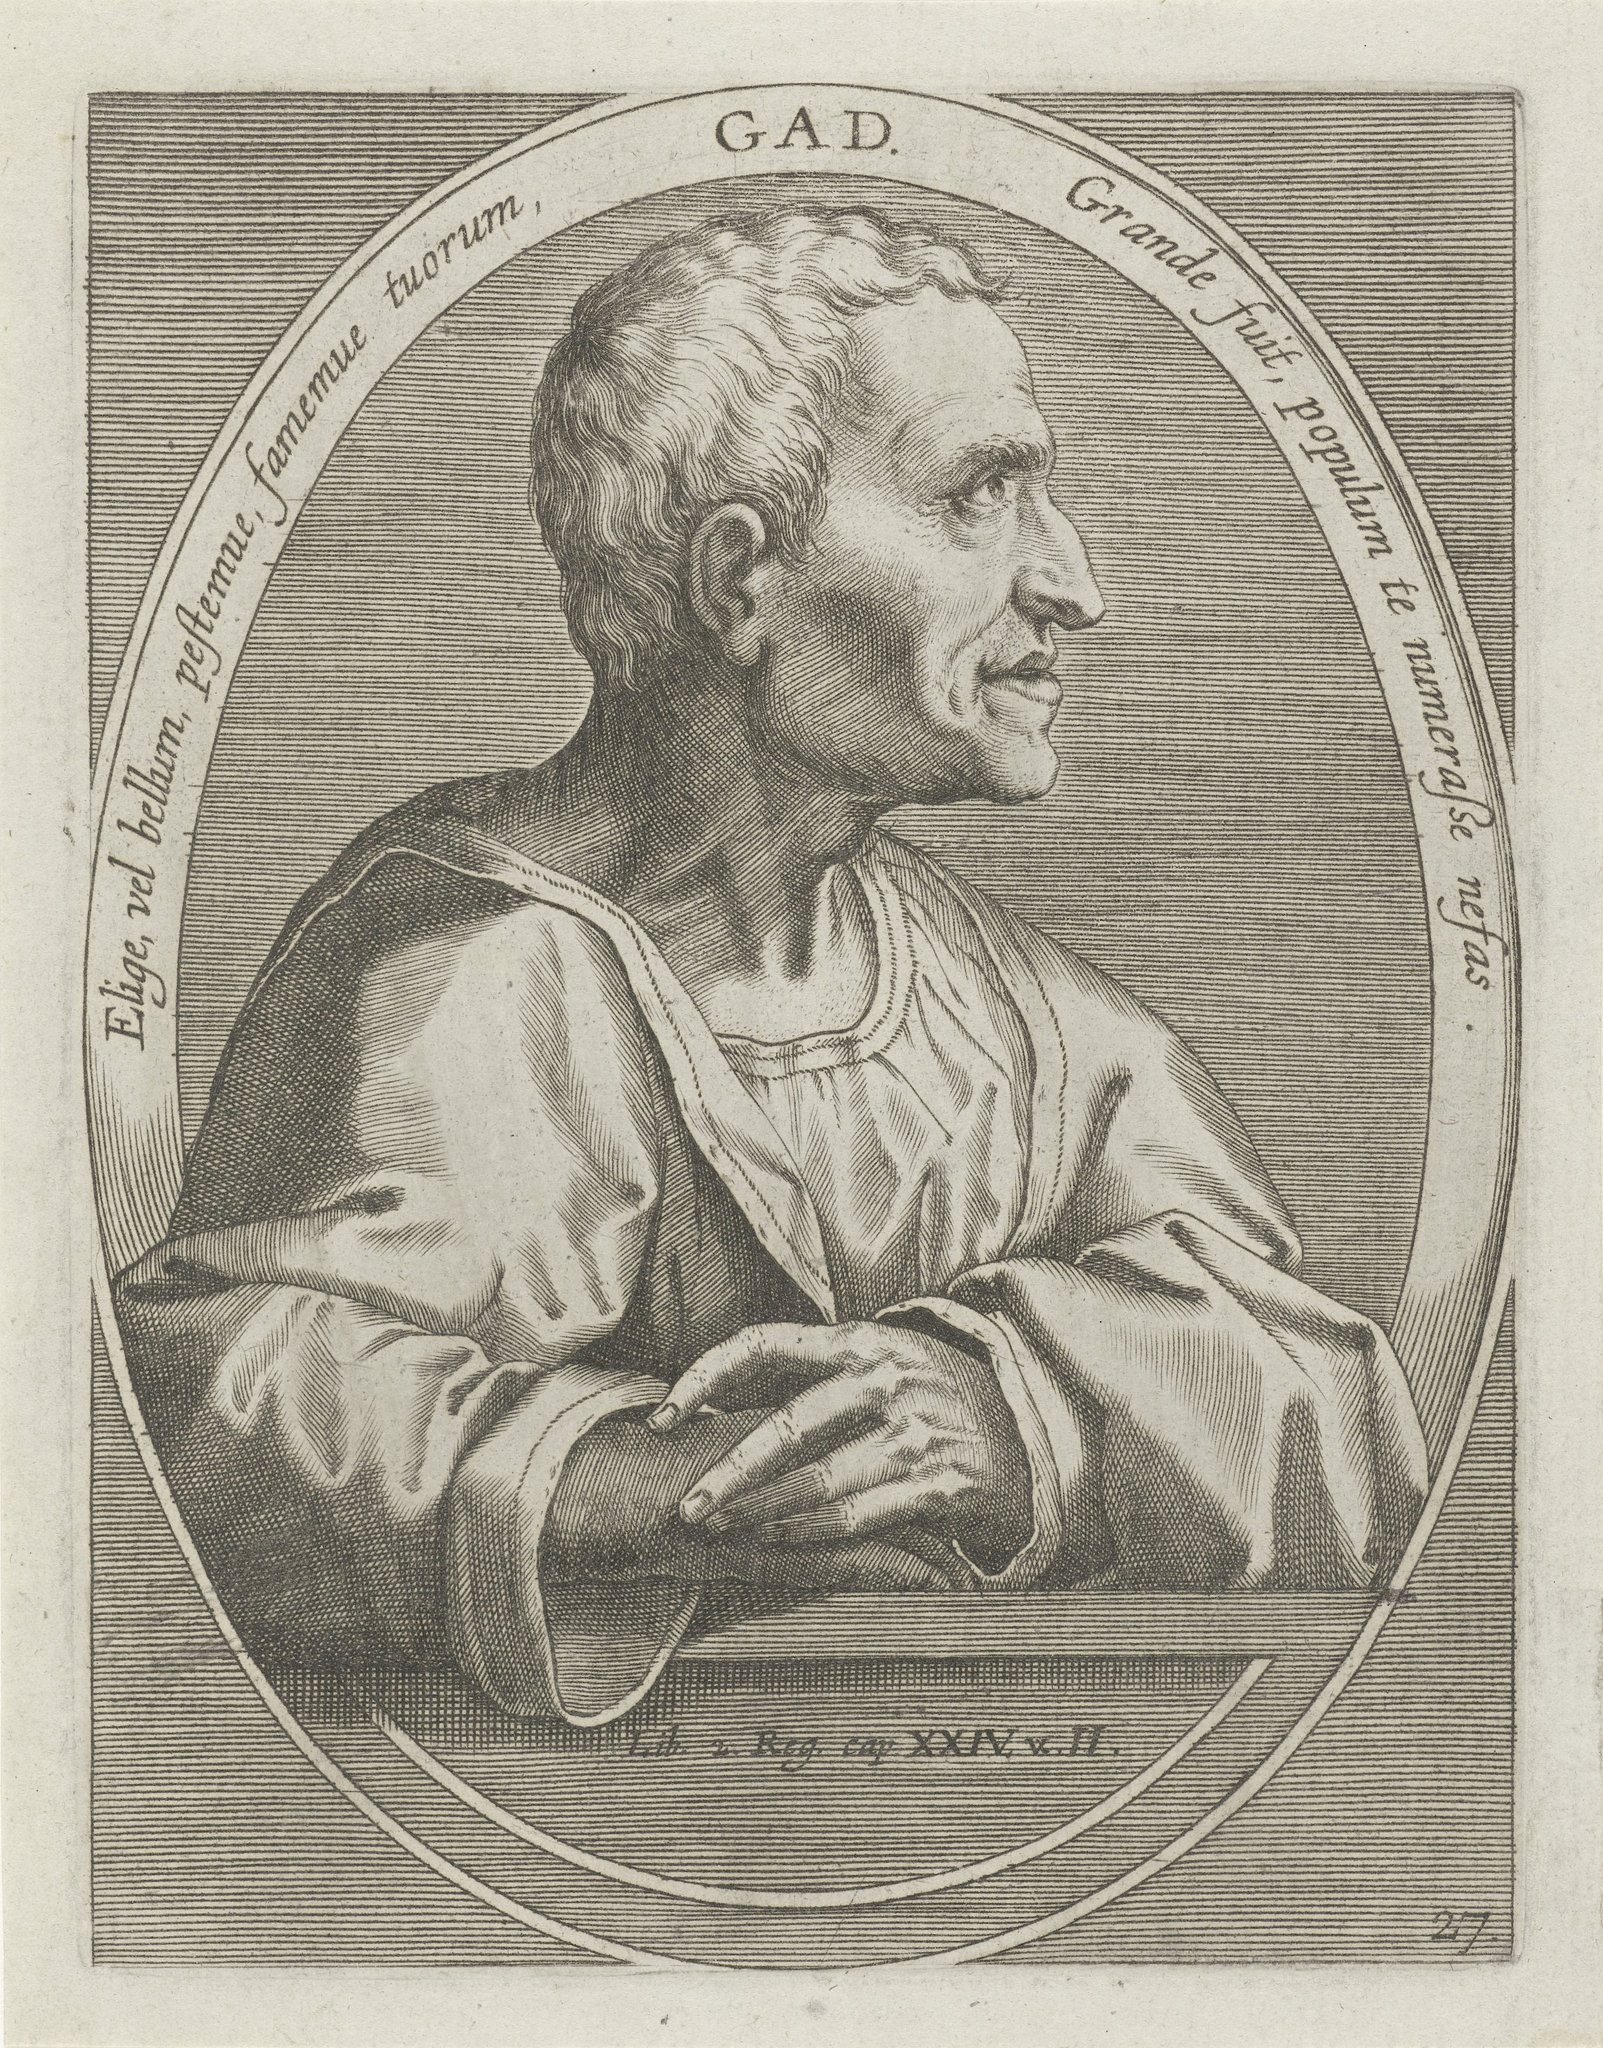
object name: print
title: Icones Prophetarum Veteris Testamenti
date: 1613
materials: paper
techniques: engraving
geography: antwerp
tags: (single) prophet, unspecified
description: De profeet Gad in een Romeins gewaad, in ovaal met Latijns randschrift.